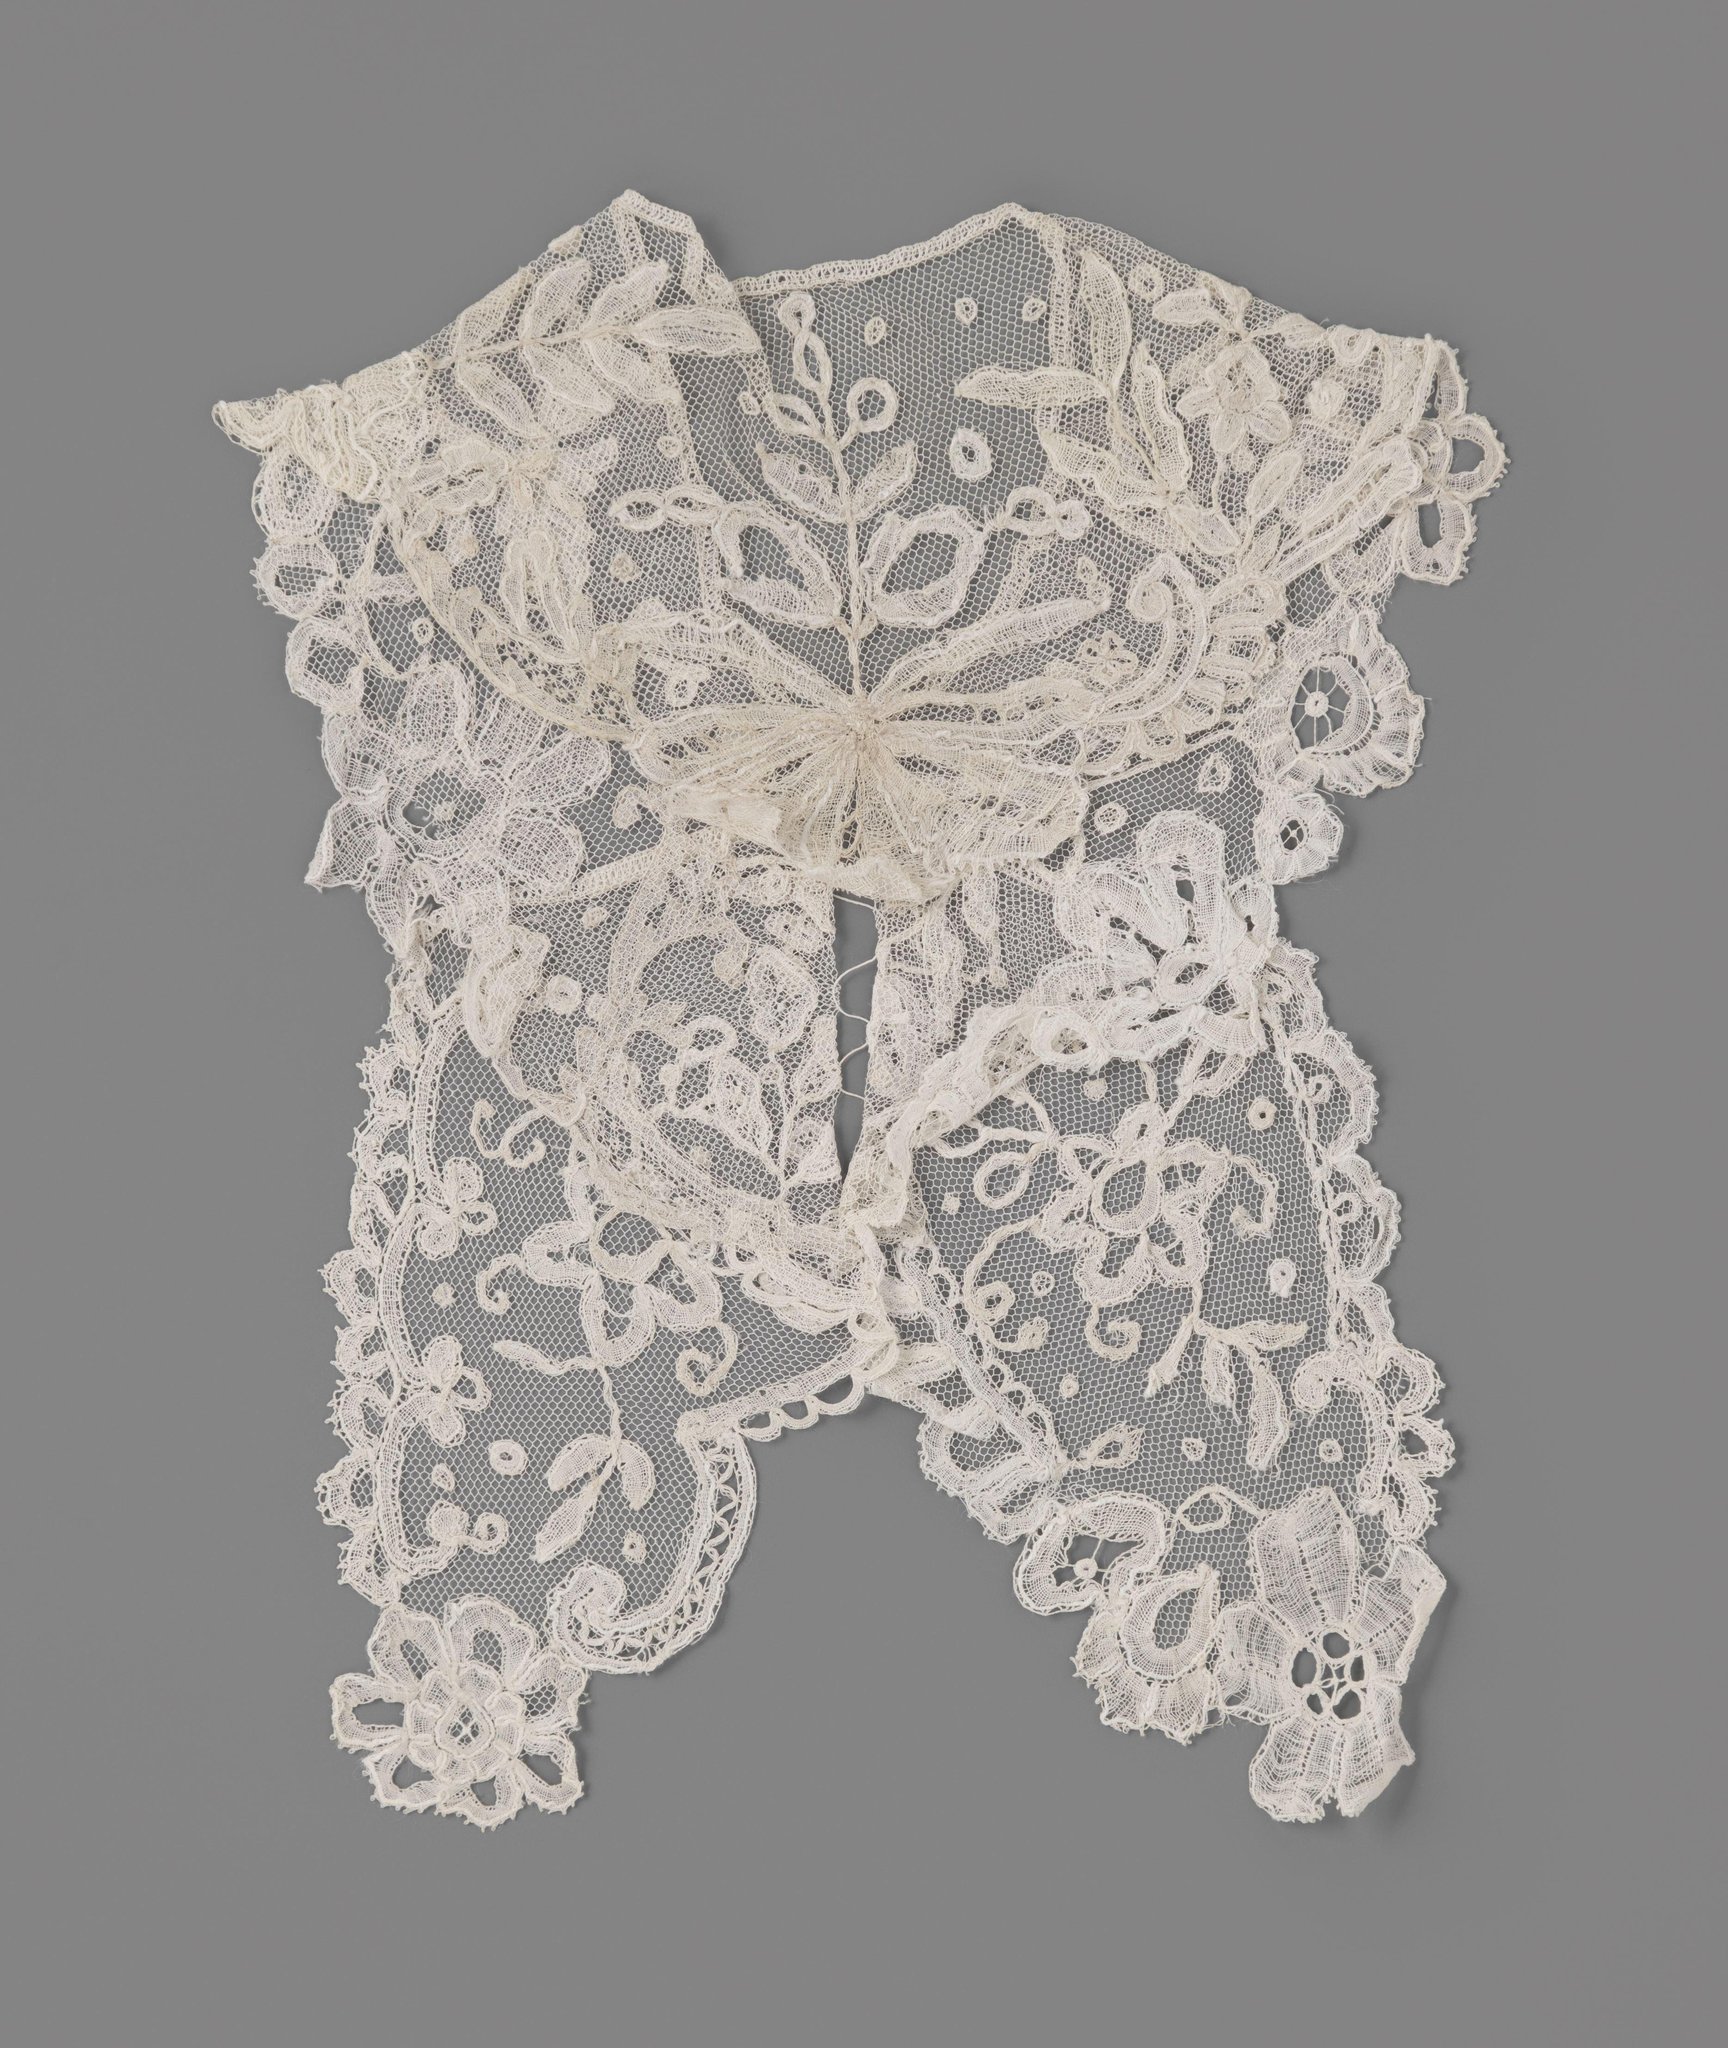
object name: clothing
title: Fragment met kloskant geappliceerd op tule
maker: Anonymous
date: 1850-1920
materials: lace, fiber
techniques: lace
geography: western europe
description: Fragment (lap?) met kloskant geappliceerd op tule, onregelmatig geschulpt en voorzien van picots. Het patroon bestaat uit bloemtakken en c-vormige voluten.